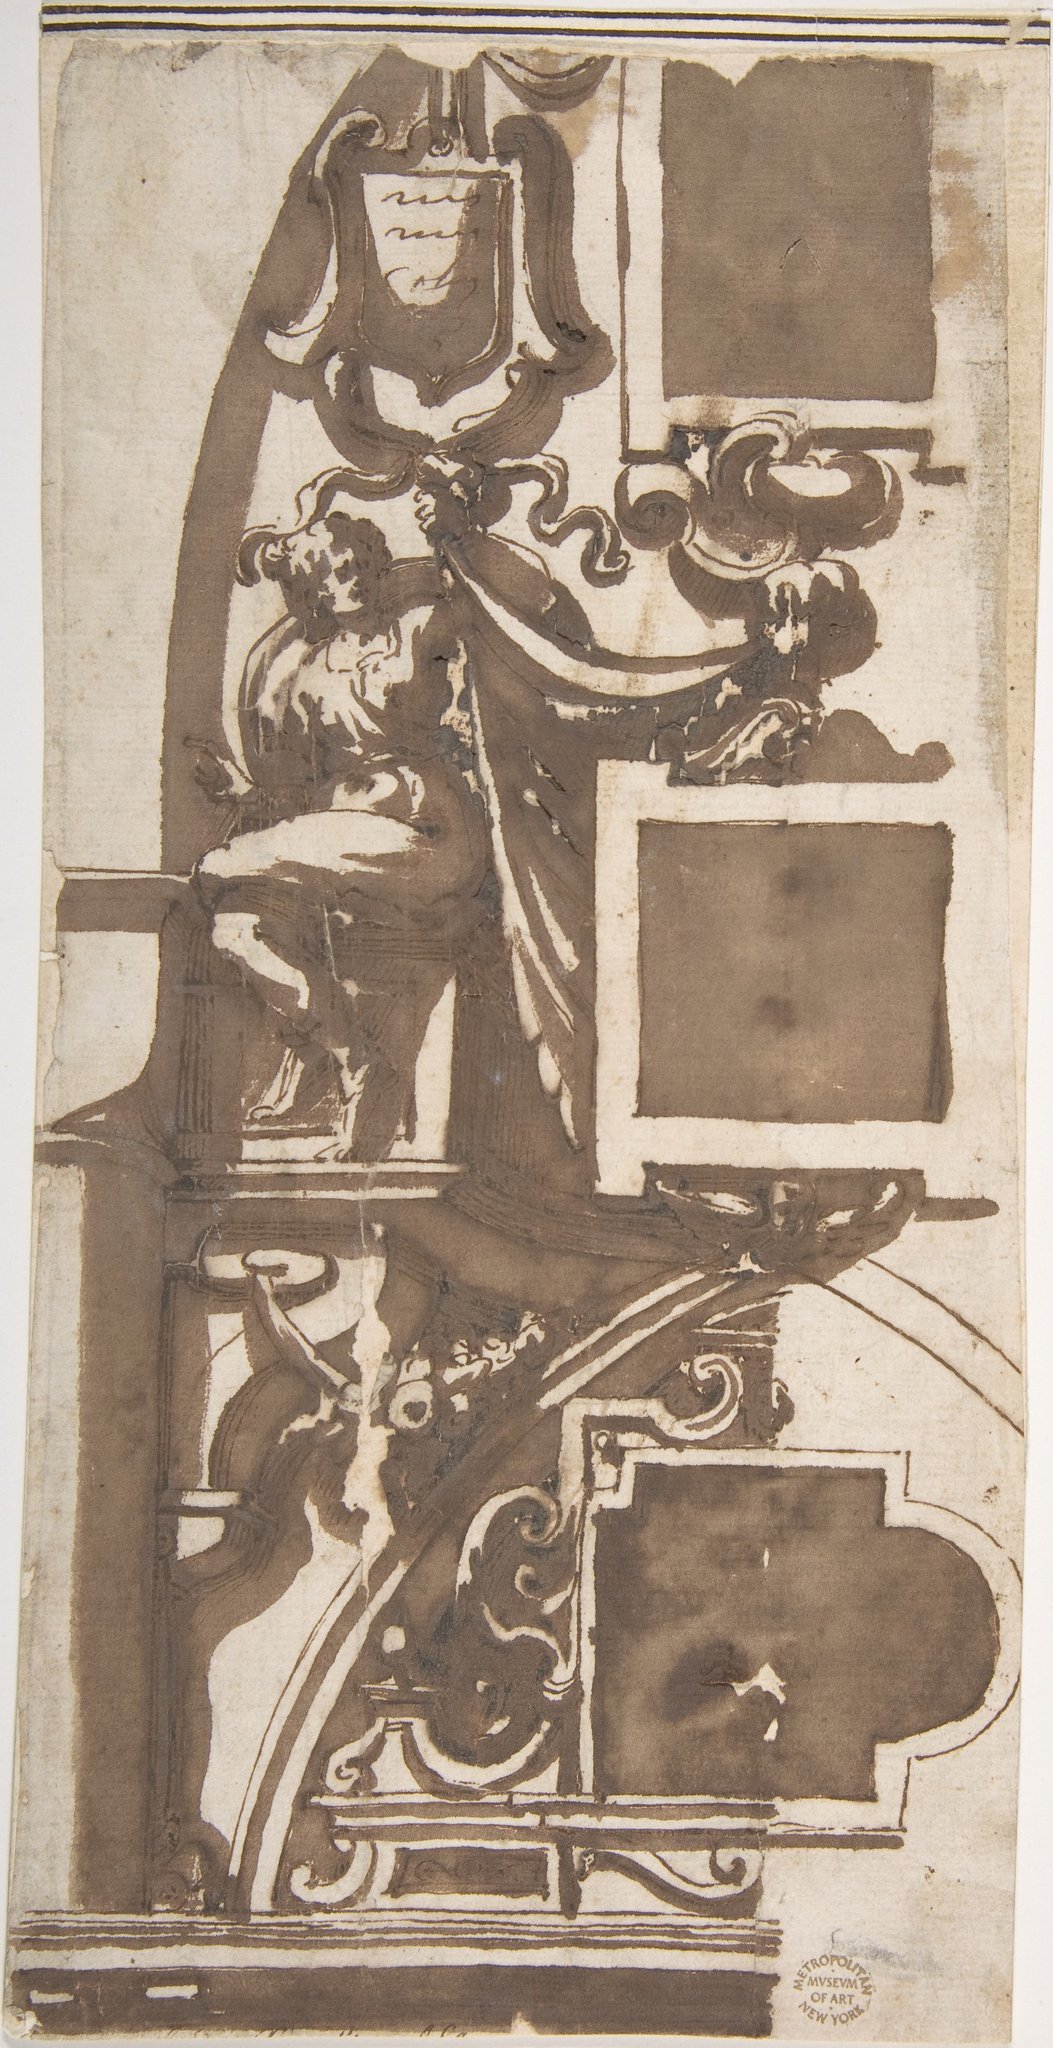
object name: drawing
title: Project for Decoration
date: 1553-1615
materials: ink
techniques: brush, pen, wash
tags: human figures